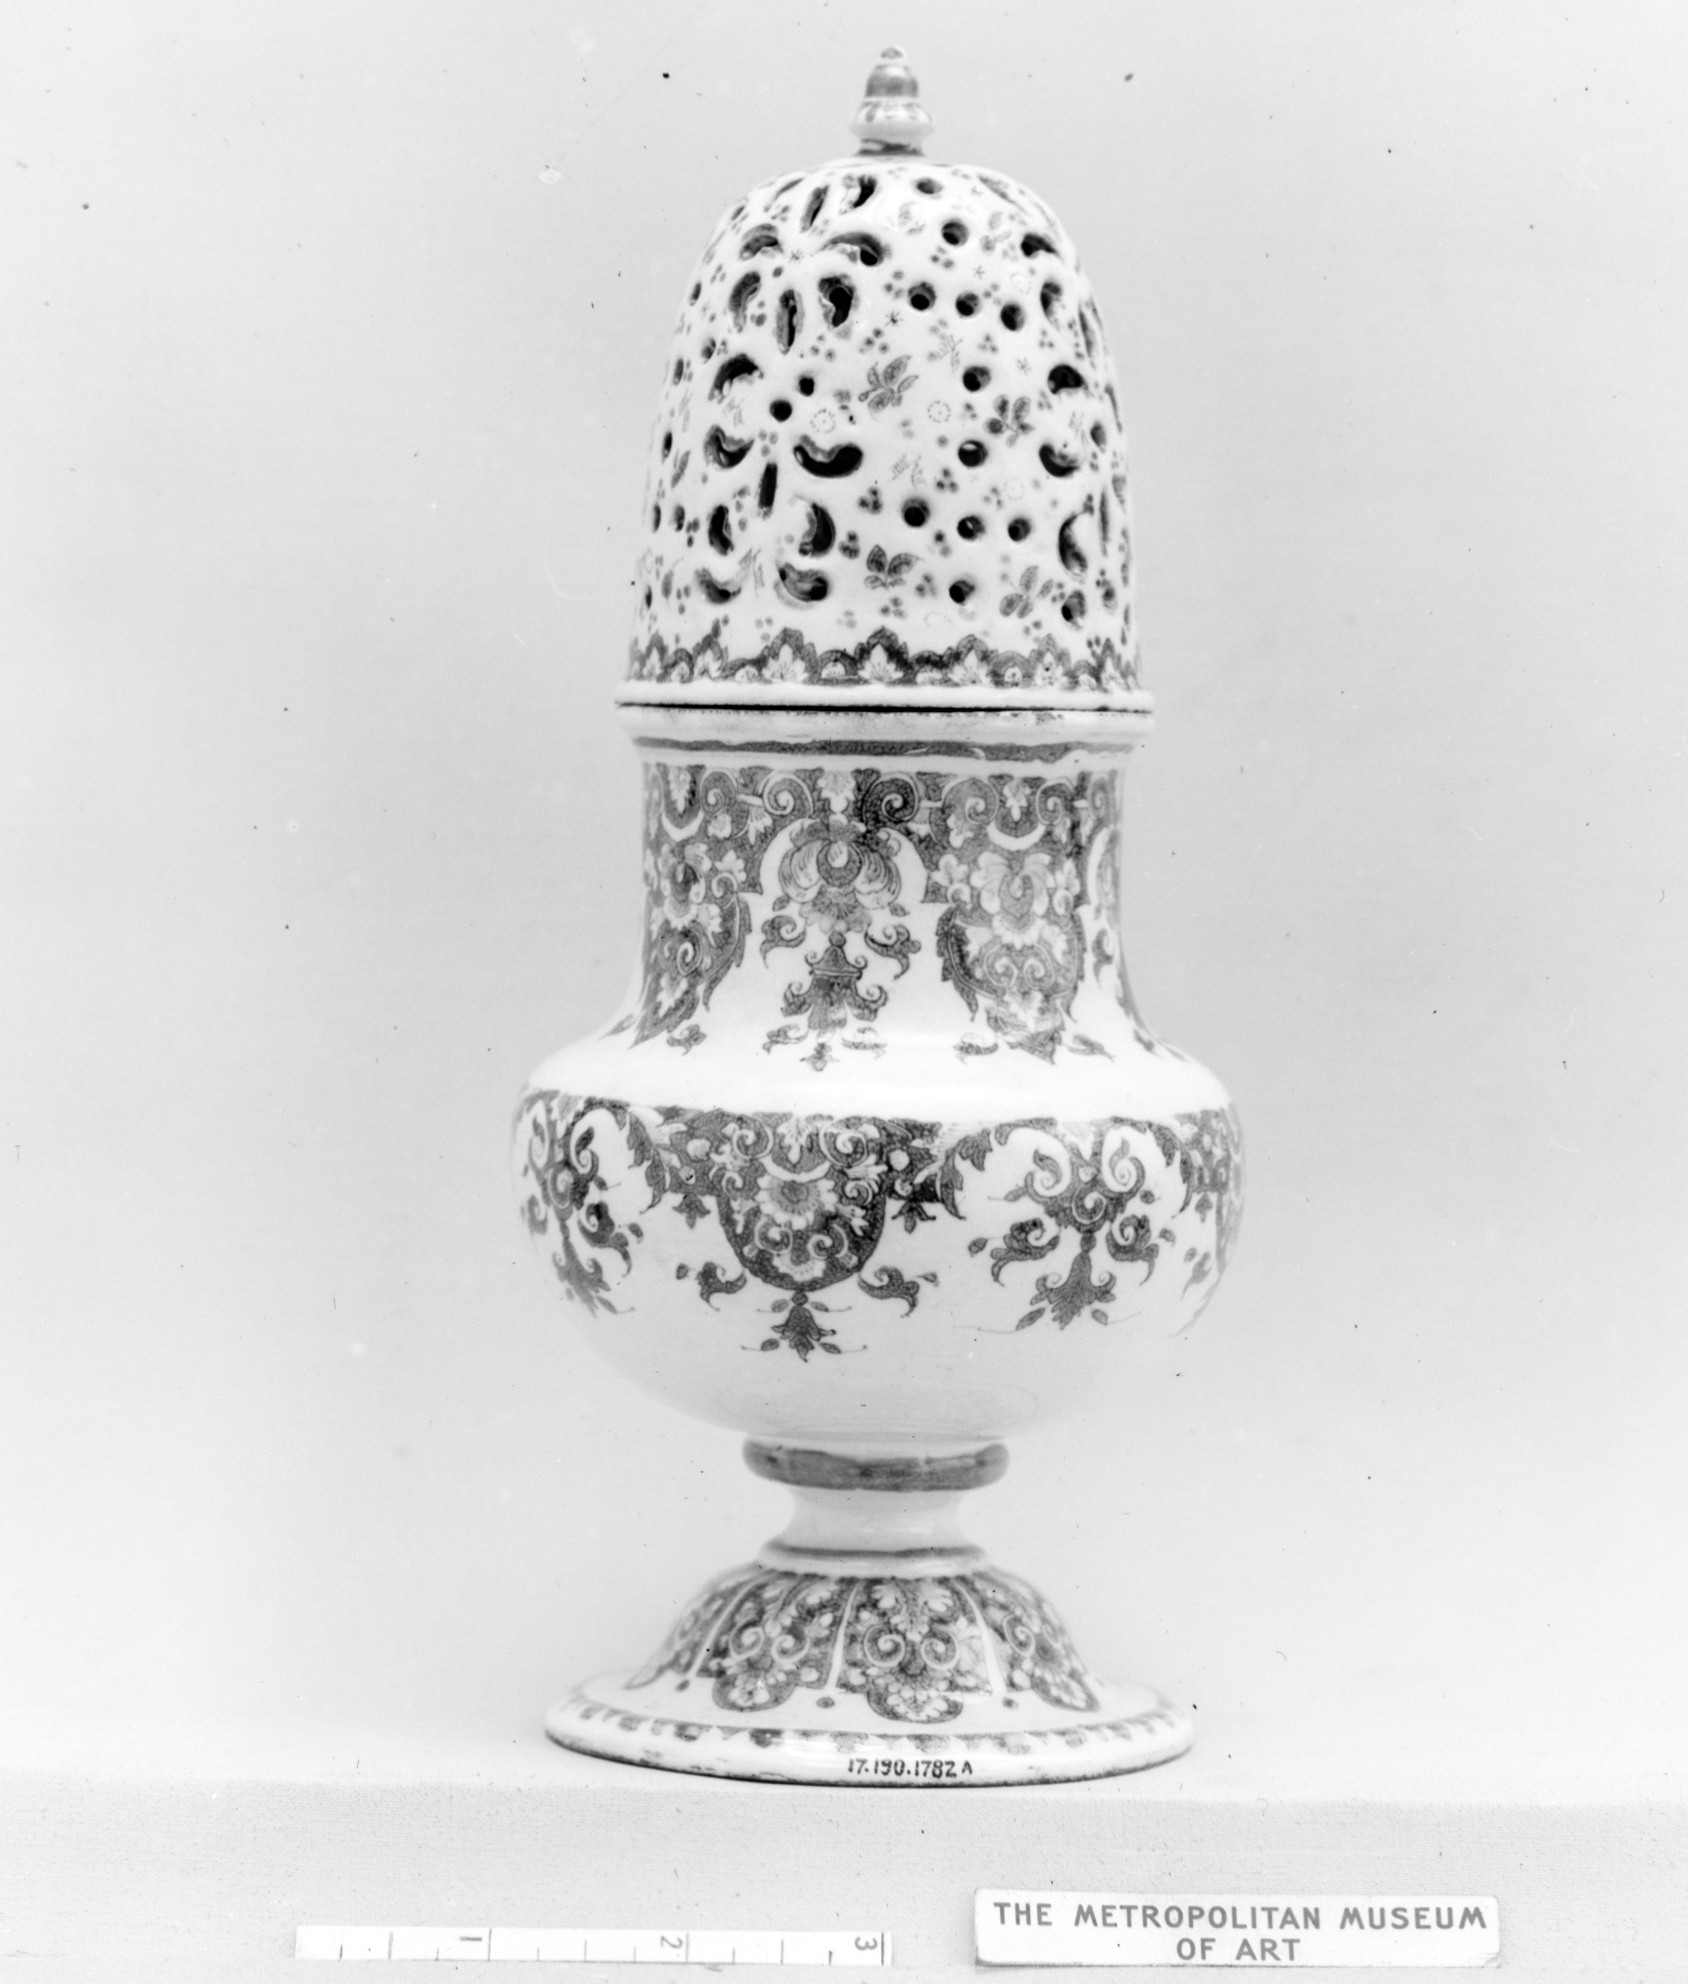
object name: sugar caster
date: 1720-1730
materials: faience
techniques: glazing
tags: flowers